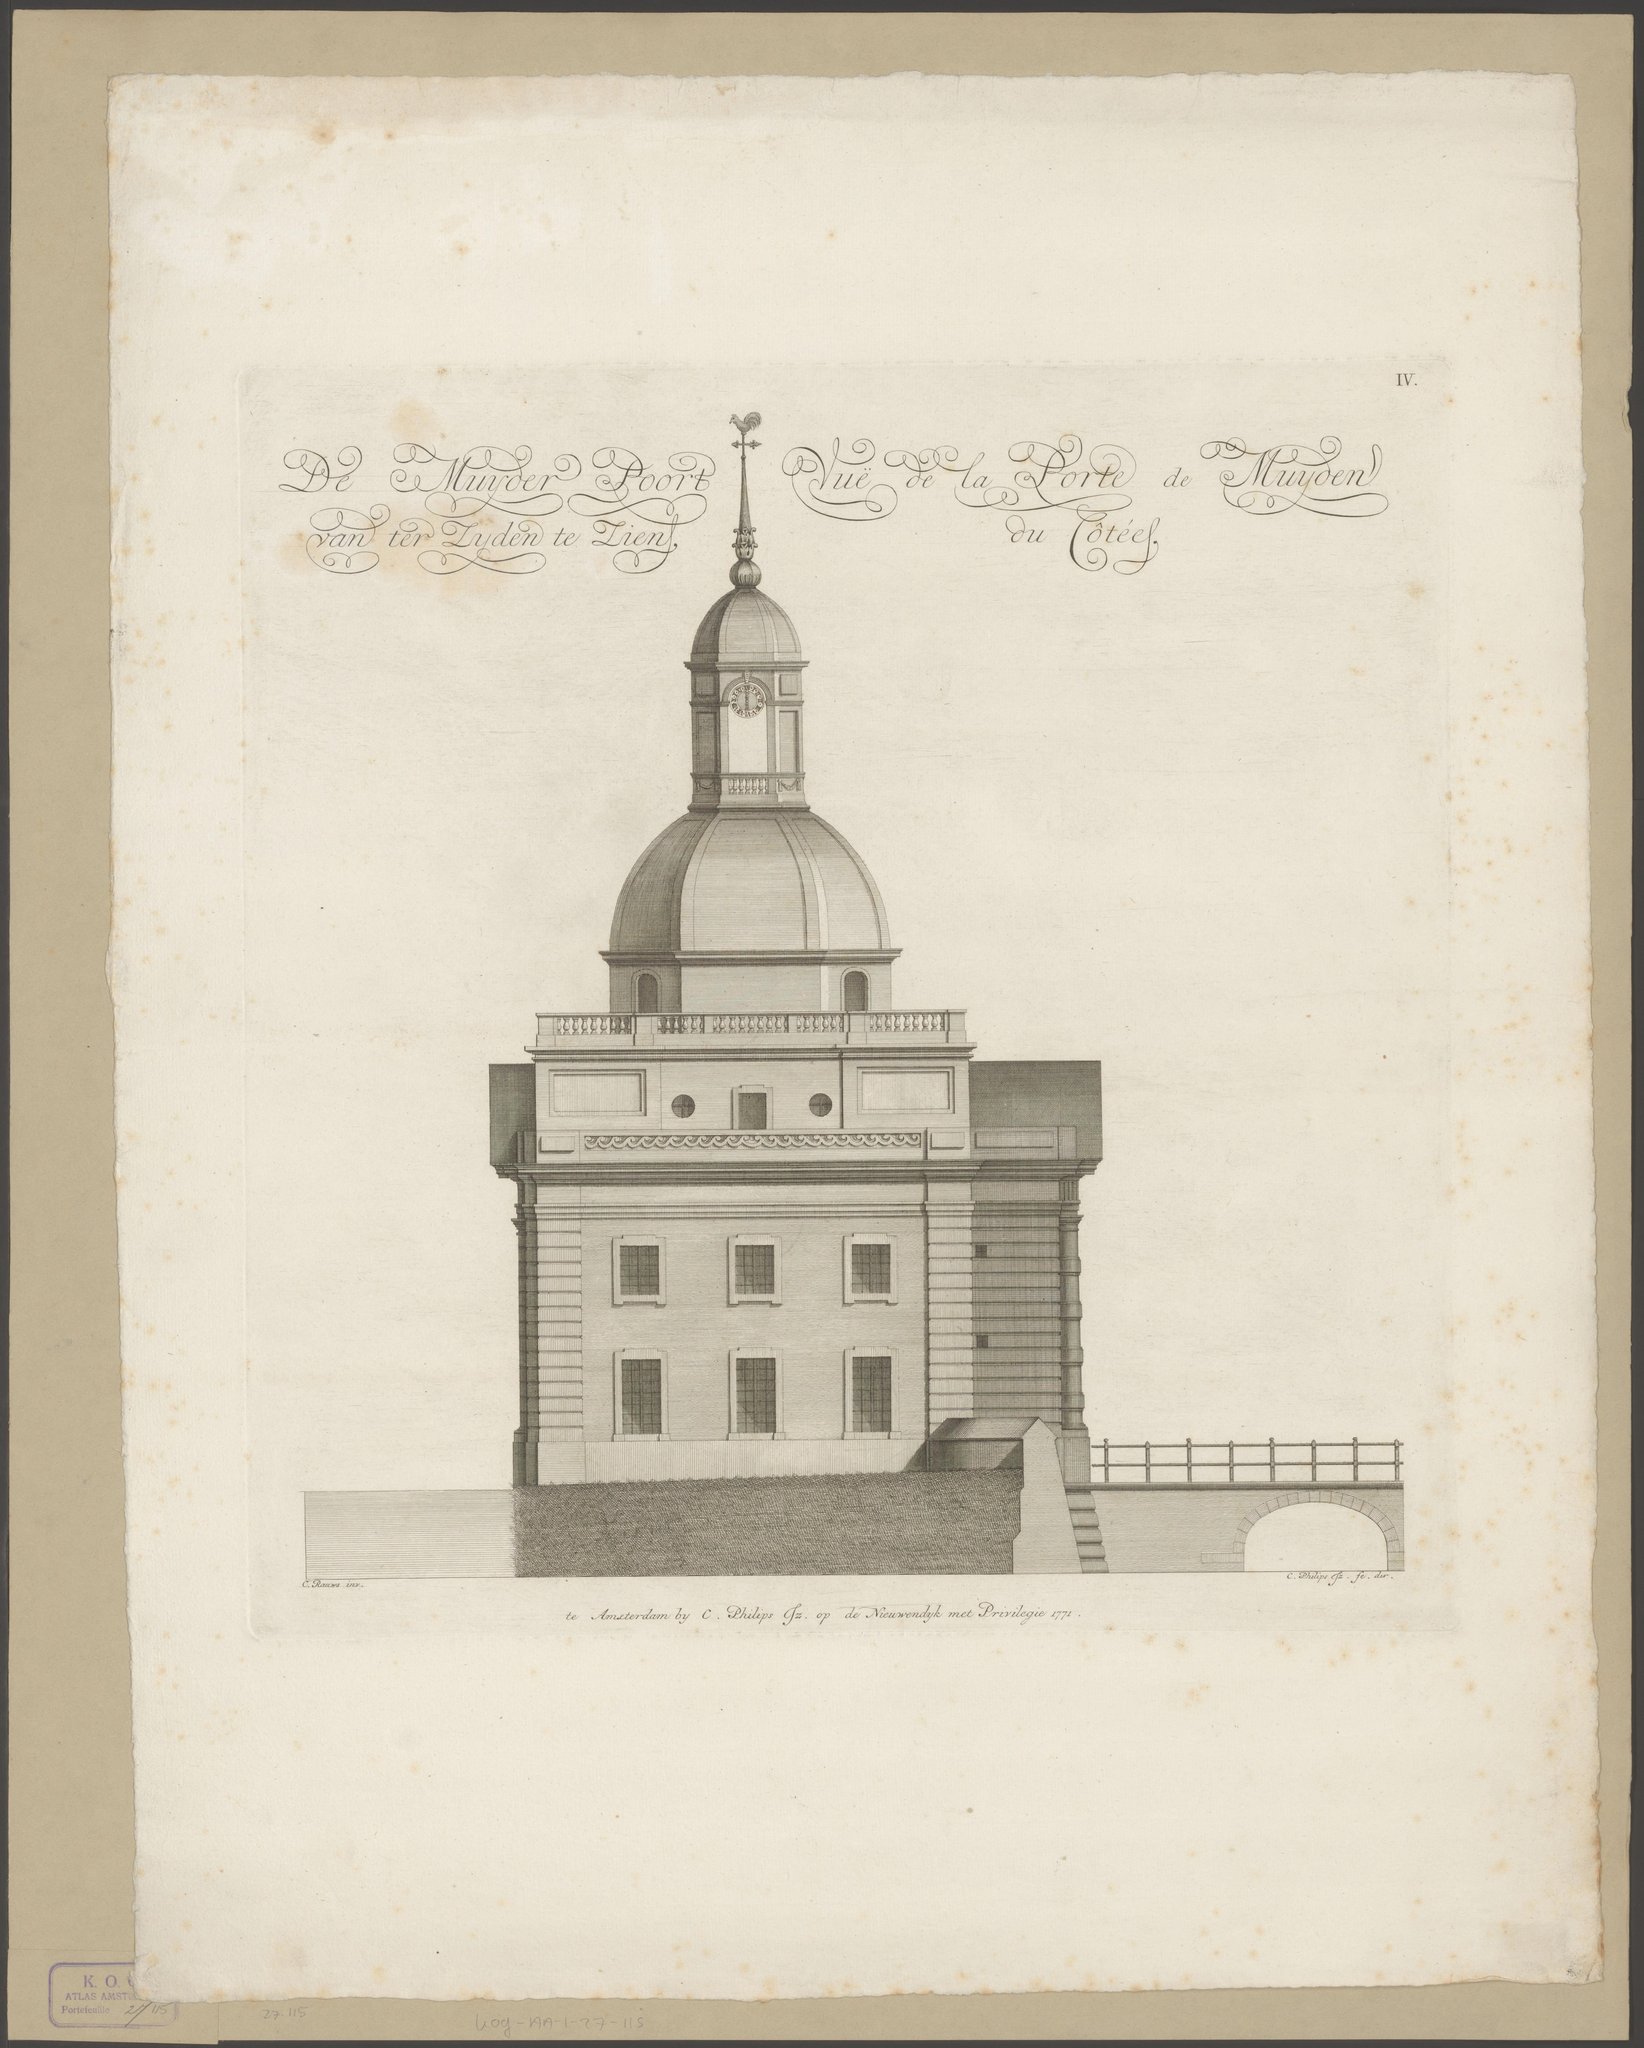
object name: print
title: De Muyder Poort van ter zyden te zien / Vuë de la Porte de Muyden du côtée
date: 1771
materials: paper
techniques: engraving, etching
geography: amsterdam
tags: series of designs, models, etc. of one architectural project, exterior ~ architectural design or model, city-gate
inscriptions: collector's mark: Lugt 1641b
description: Zijkant van de Tweede Muiderpoort te Amsterdam, met links de kant die binnen de stad lag en rechts de kant met de toegangsbrug buiten te stad. Boven de titel in het Nederlands en Frans. Rechtsboven genummerd: IV. Onderdeel van een serie van zes prenten van de Tweede Muiderpoort, gemaakt naar de ontwerptekeningen van stadsbouwmeester Cornelis Rauws. Deze stadspoort werd in 1770 gebouwd nadat de Eerste Muiderpoort in 1769 verzakte. Onderwerpsrubriek binnen de Atlas Amsterdam: Poorten, verzamelbladen, J. Tweede Muiderpoort.